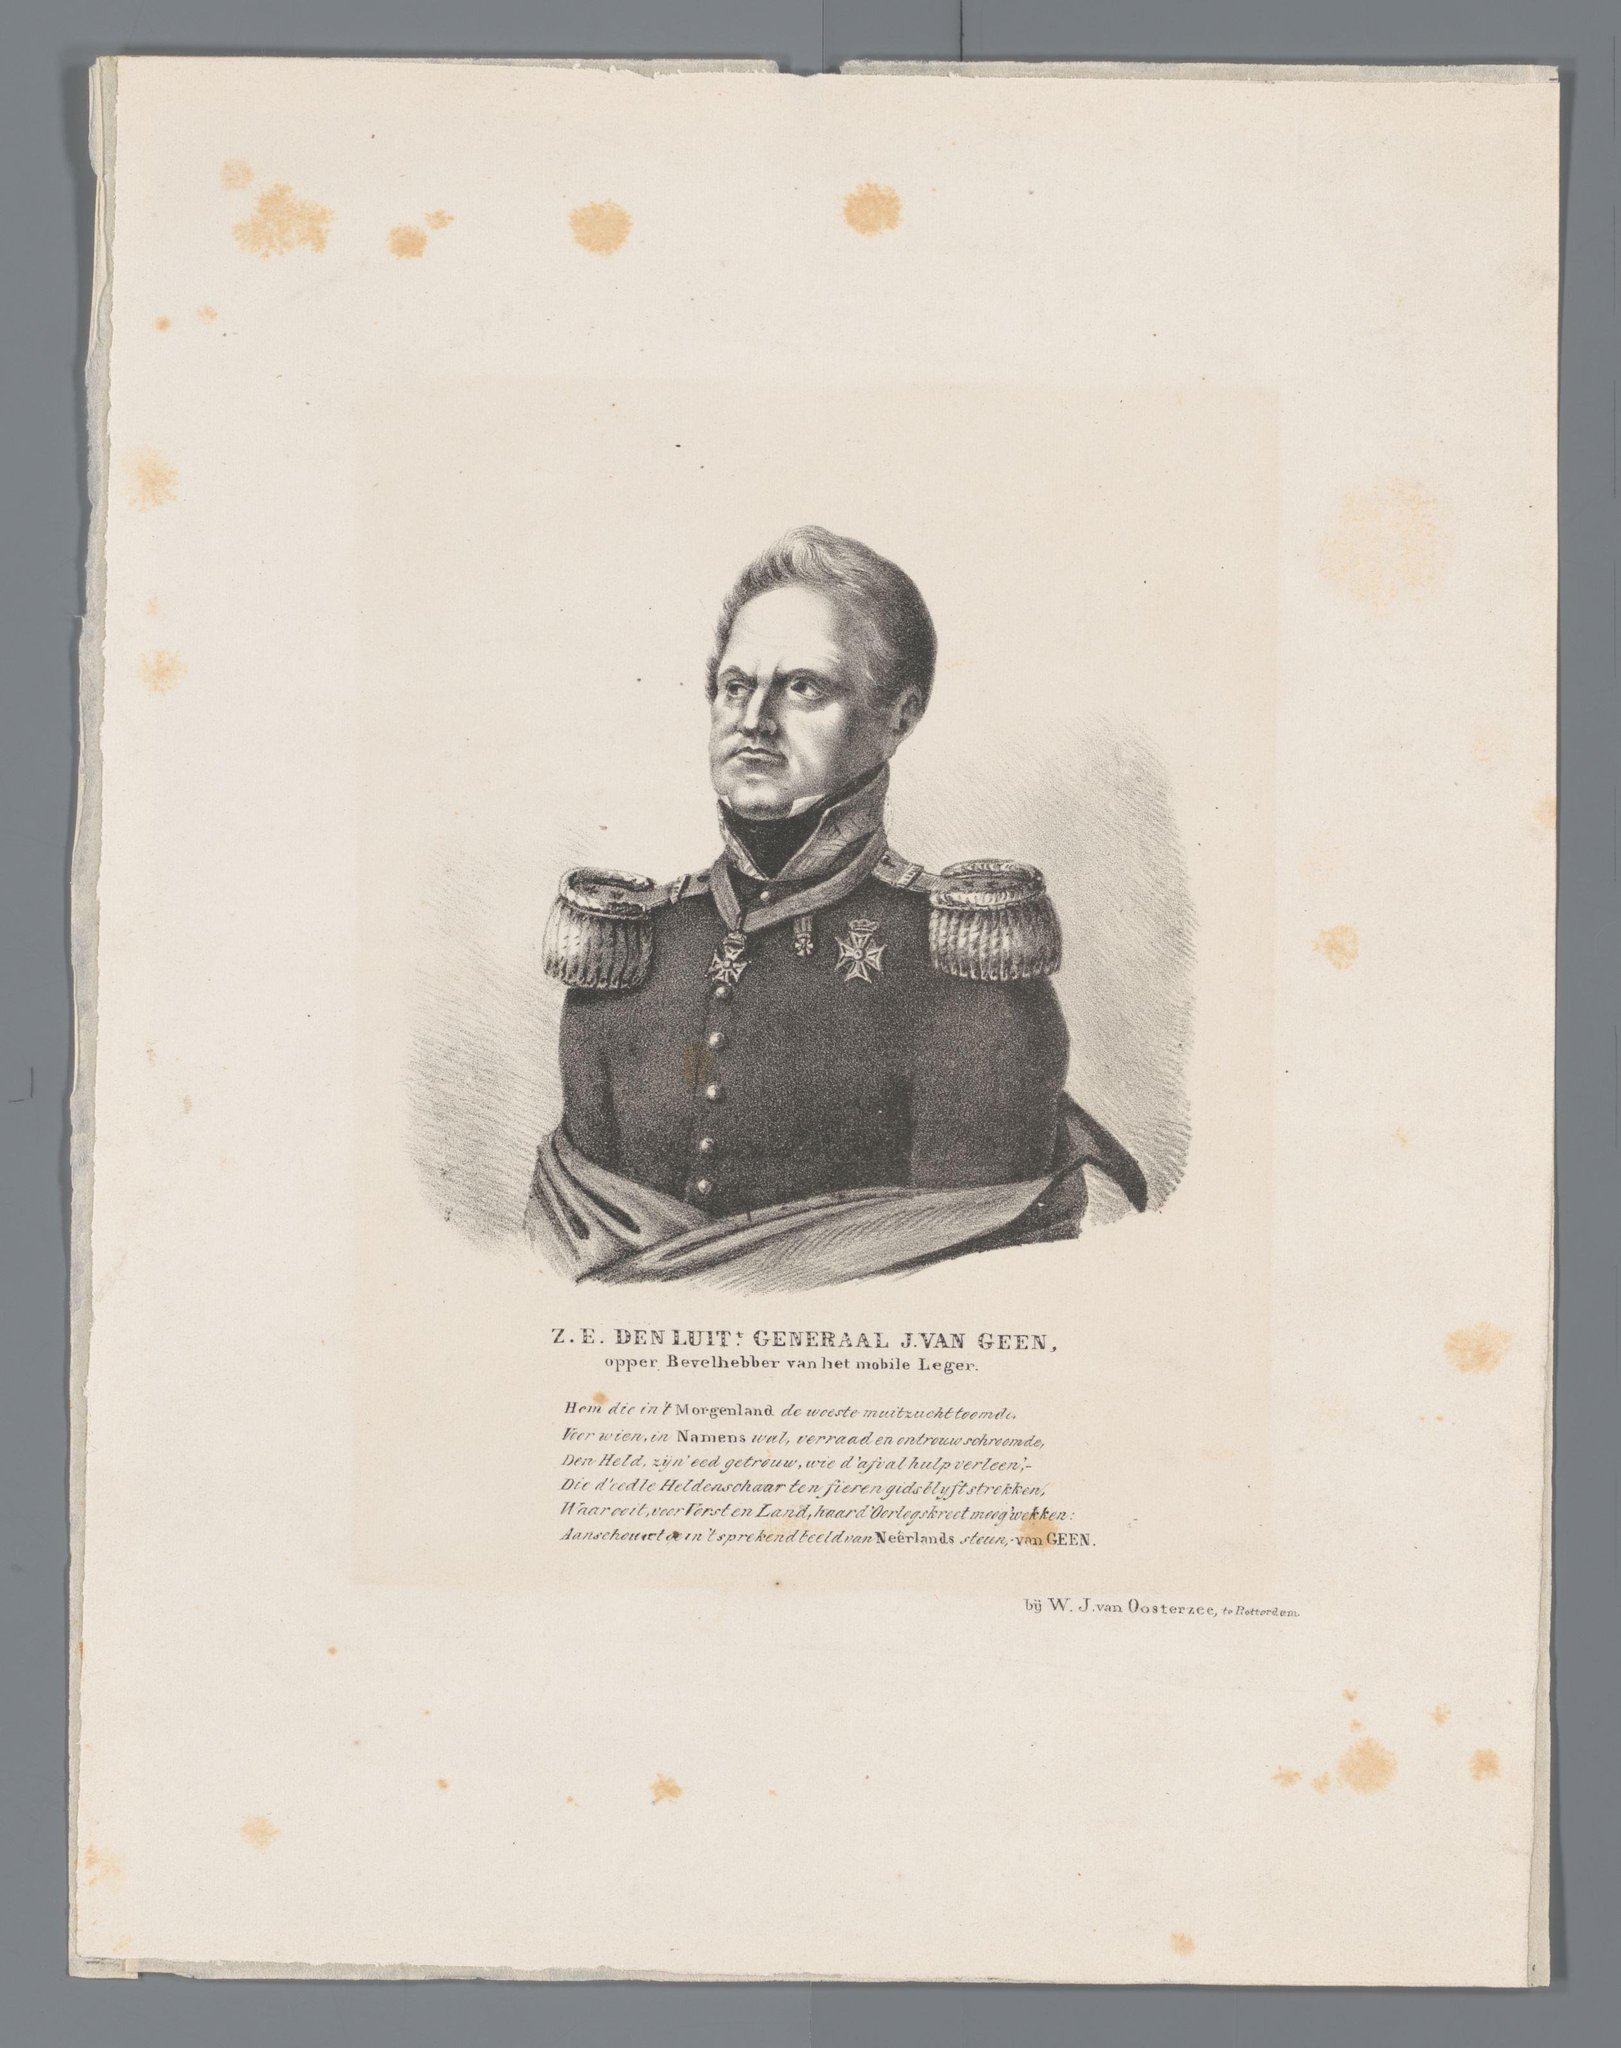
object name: print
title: Z.E. den Luit Generaal J. van Geen, opper Bevelhebber van het mobile Leger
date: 1830-1845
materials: paper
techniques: lithograph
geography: rotterdam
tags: historical persons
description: Portret van Joseph Jacobus baron van Geen, borststuk, in uniform, ietwat naar links, met drie eretekens. Onderaan een zesregelig gedicht.